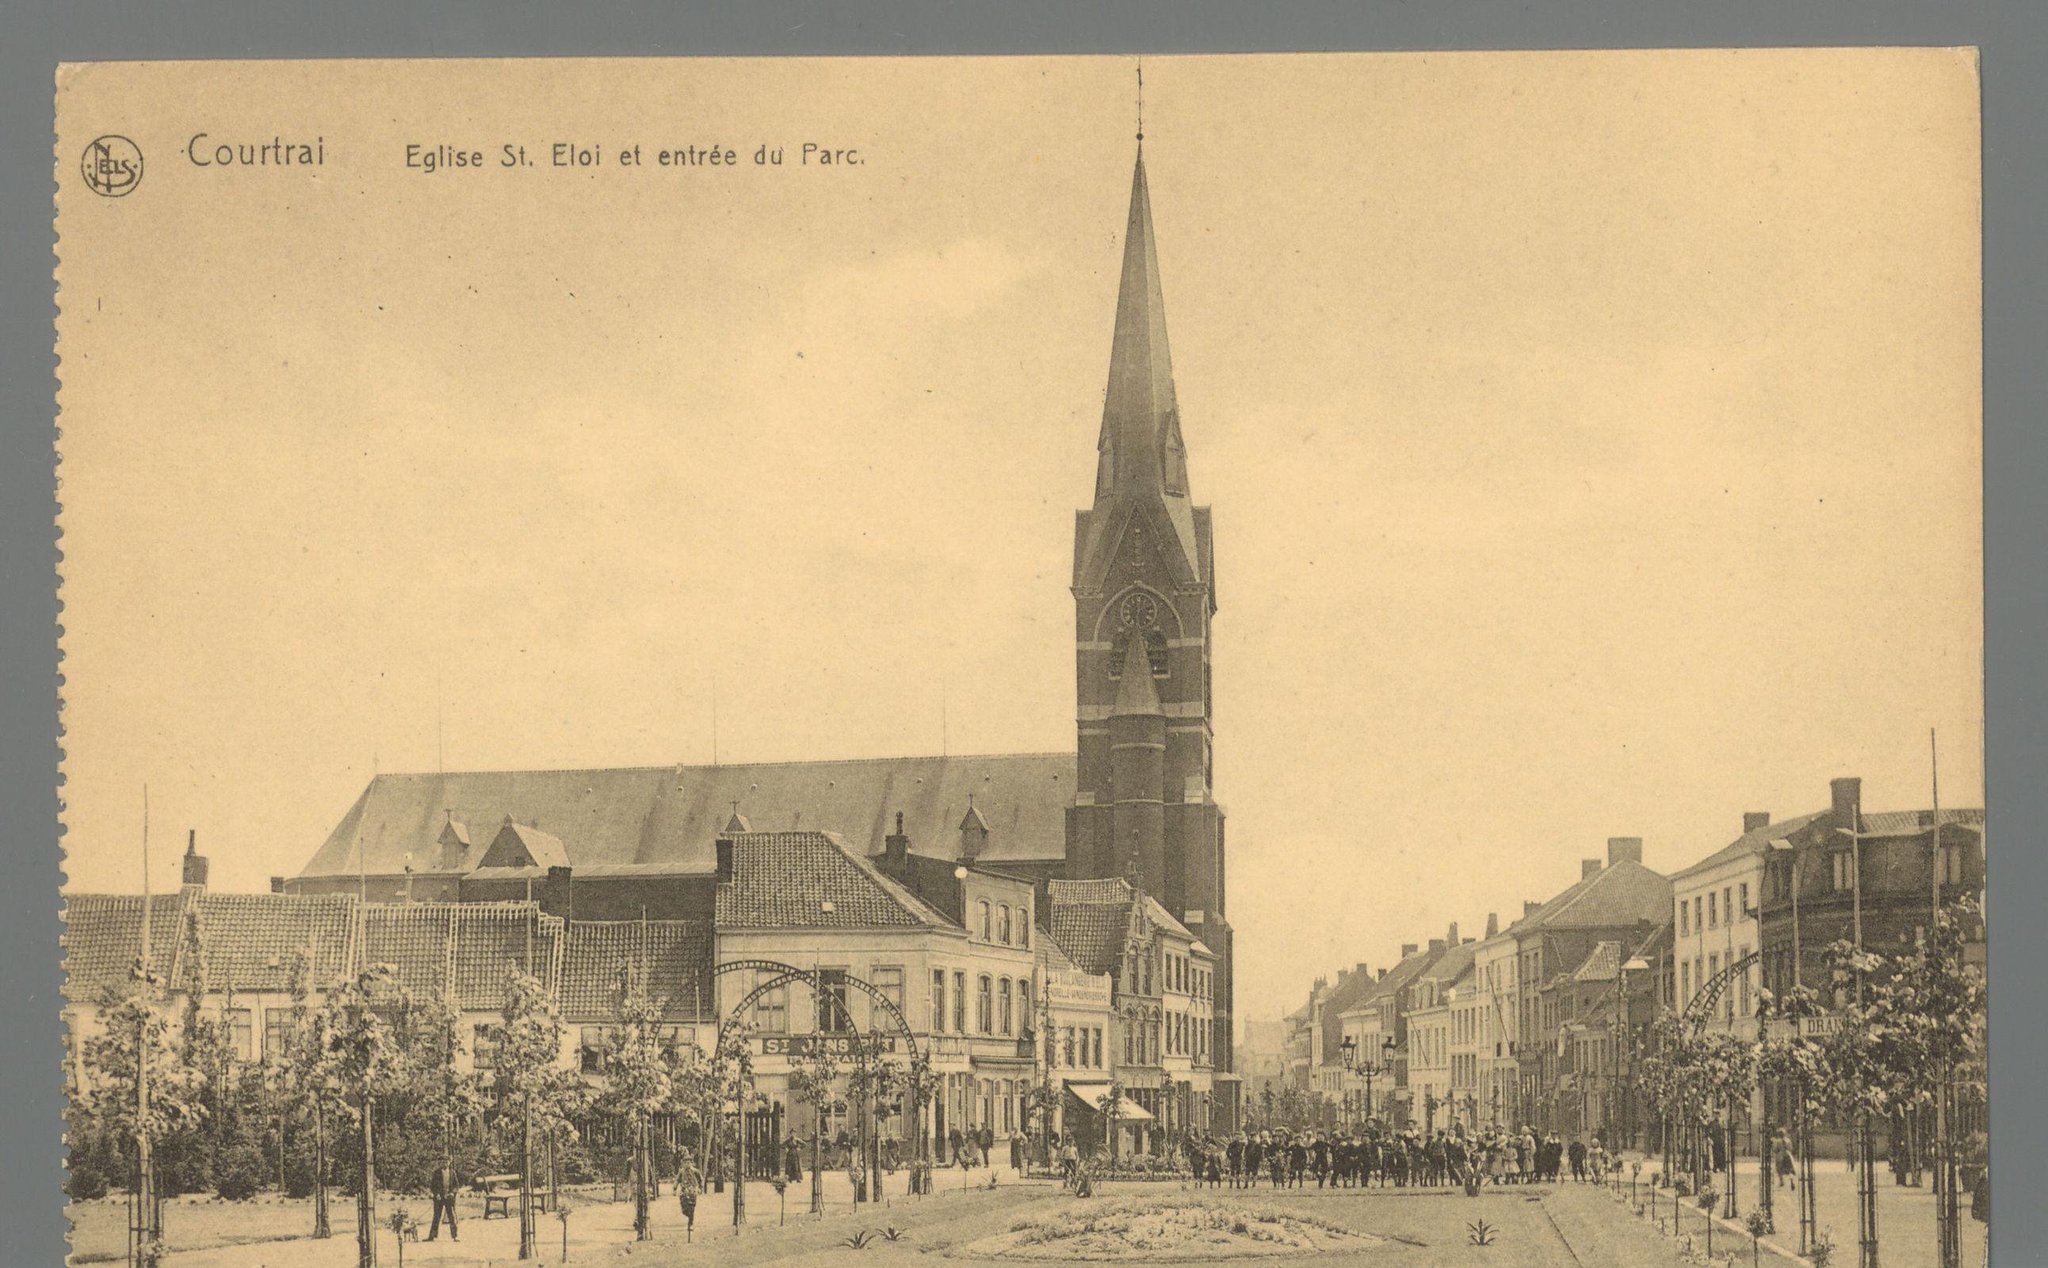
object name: ansichtkaart, prentbriefkaart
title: Courtrai. Eglise St. Eloi et entrée du Parc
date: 1913-1930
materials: cardboard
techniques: photograph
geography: kortrijk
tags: public gardens, park (+ city(-scape) with figures, staffage), church (exterior)